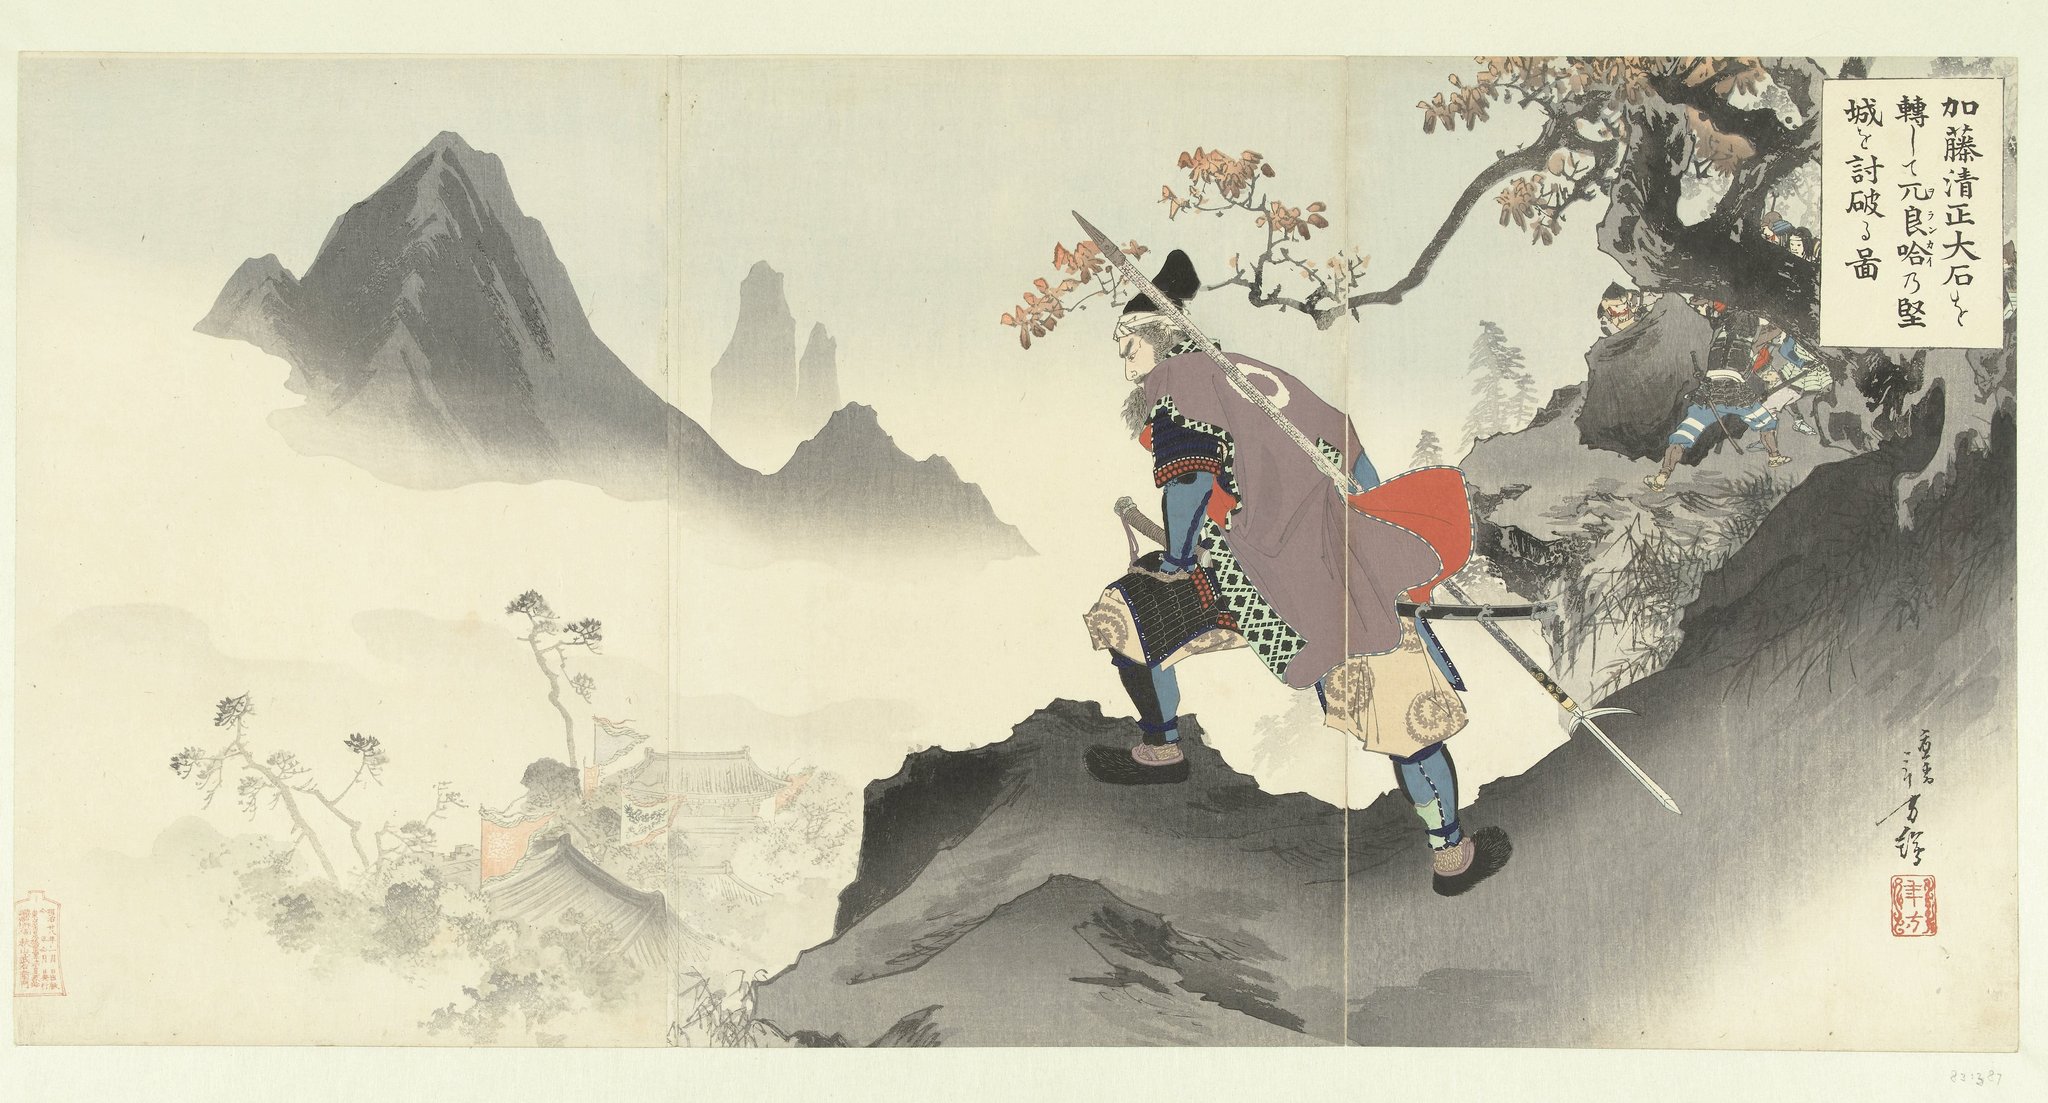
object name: triptych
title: Kato Kiyomasa oishi korogashite Orankai no kenjo o uchiyaburu zu.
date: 1801-1895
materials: paper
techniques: woodcut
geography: tokyo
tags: the soldier; the soldier's life, mountains (+ landscape with figures, staffage)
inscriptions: collector's mark: Lugt 2228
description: Generaal Kato Kiyomasa staand op een rots, omlaag kijkend naar het paleis van zijn tegenstander; op de achtergrond rollen zijn soldaten een groot rotsblok naar de rand van de berg.